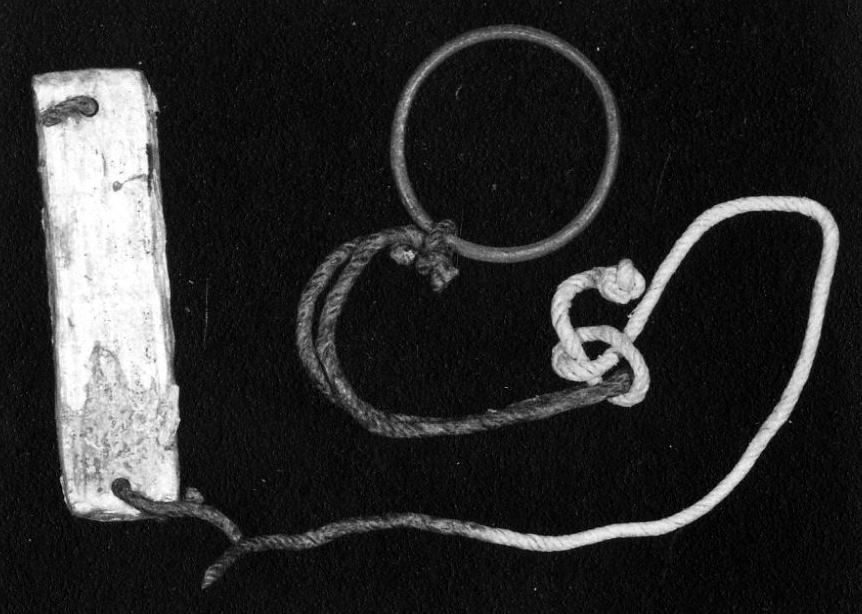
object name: plaque, bracelet, cord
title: A plaque tied to a bracelet or ring with a cord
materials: metal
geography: egypt